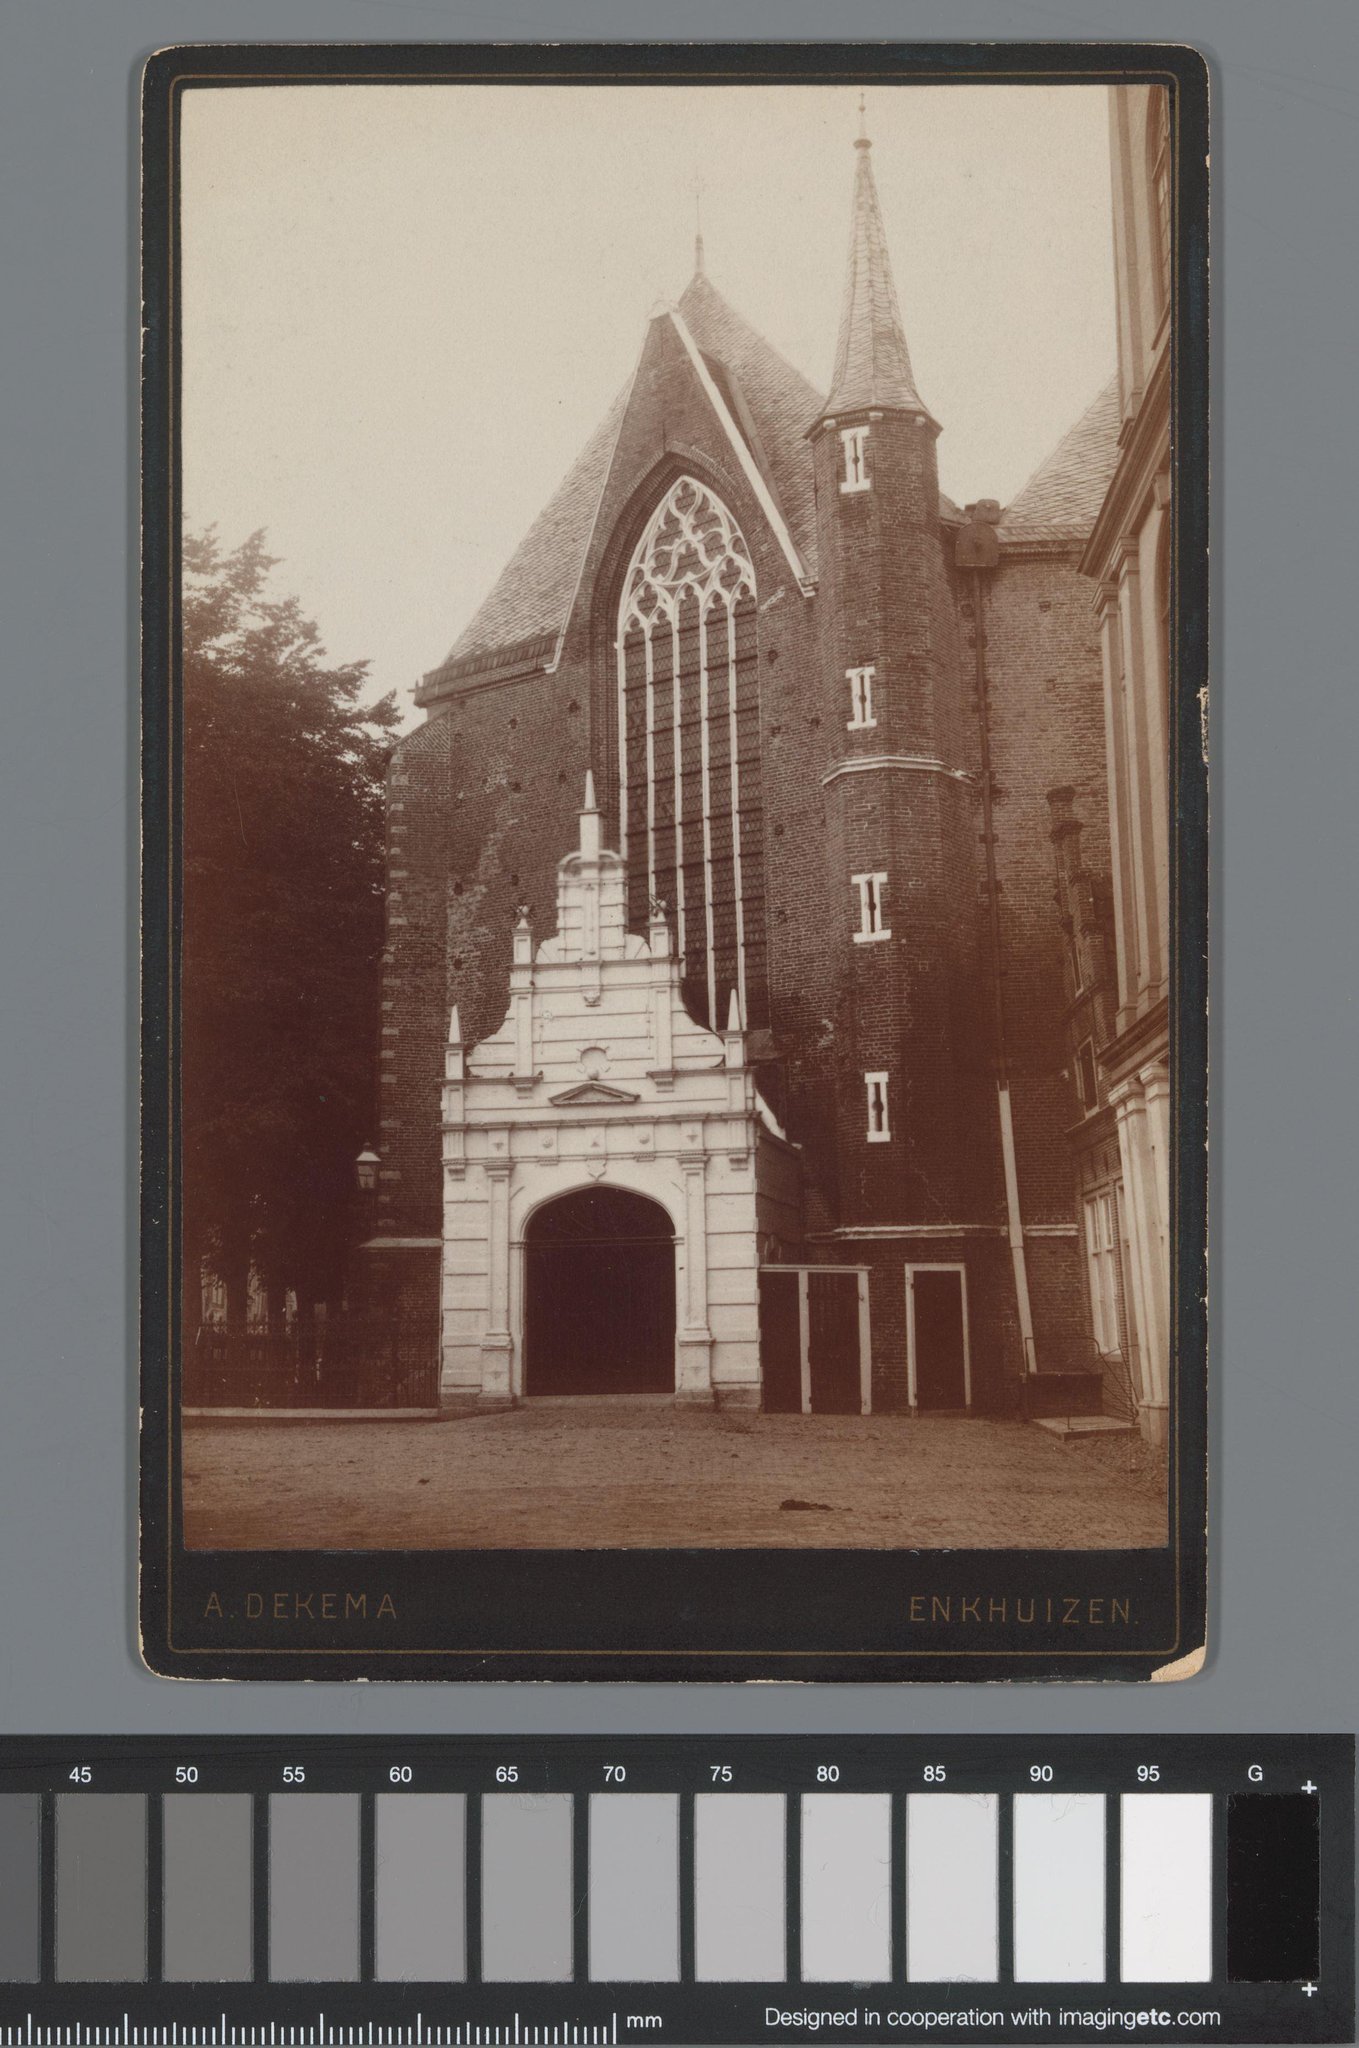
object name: photograph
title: Gedeelte van de Westerkerk te Enkhuizen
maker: albert dekema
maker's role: publisher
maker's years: 1824-1909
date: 1865-1896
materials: cardboard, photographic support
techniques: albumen print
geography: enkhuizen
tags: church (exterior)